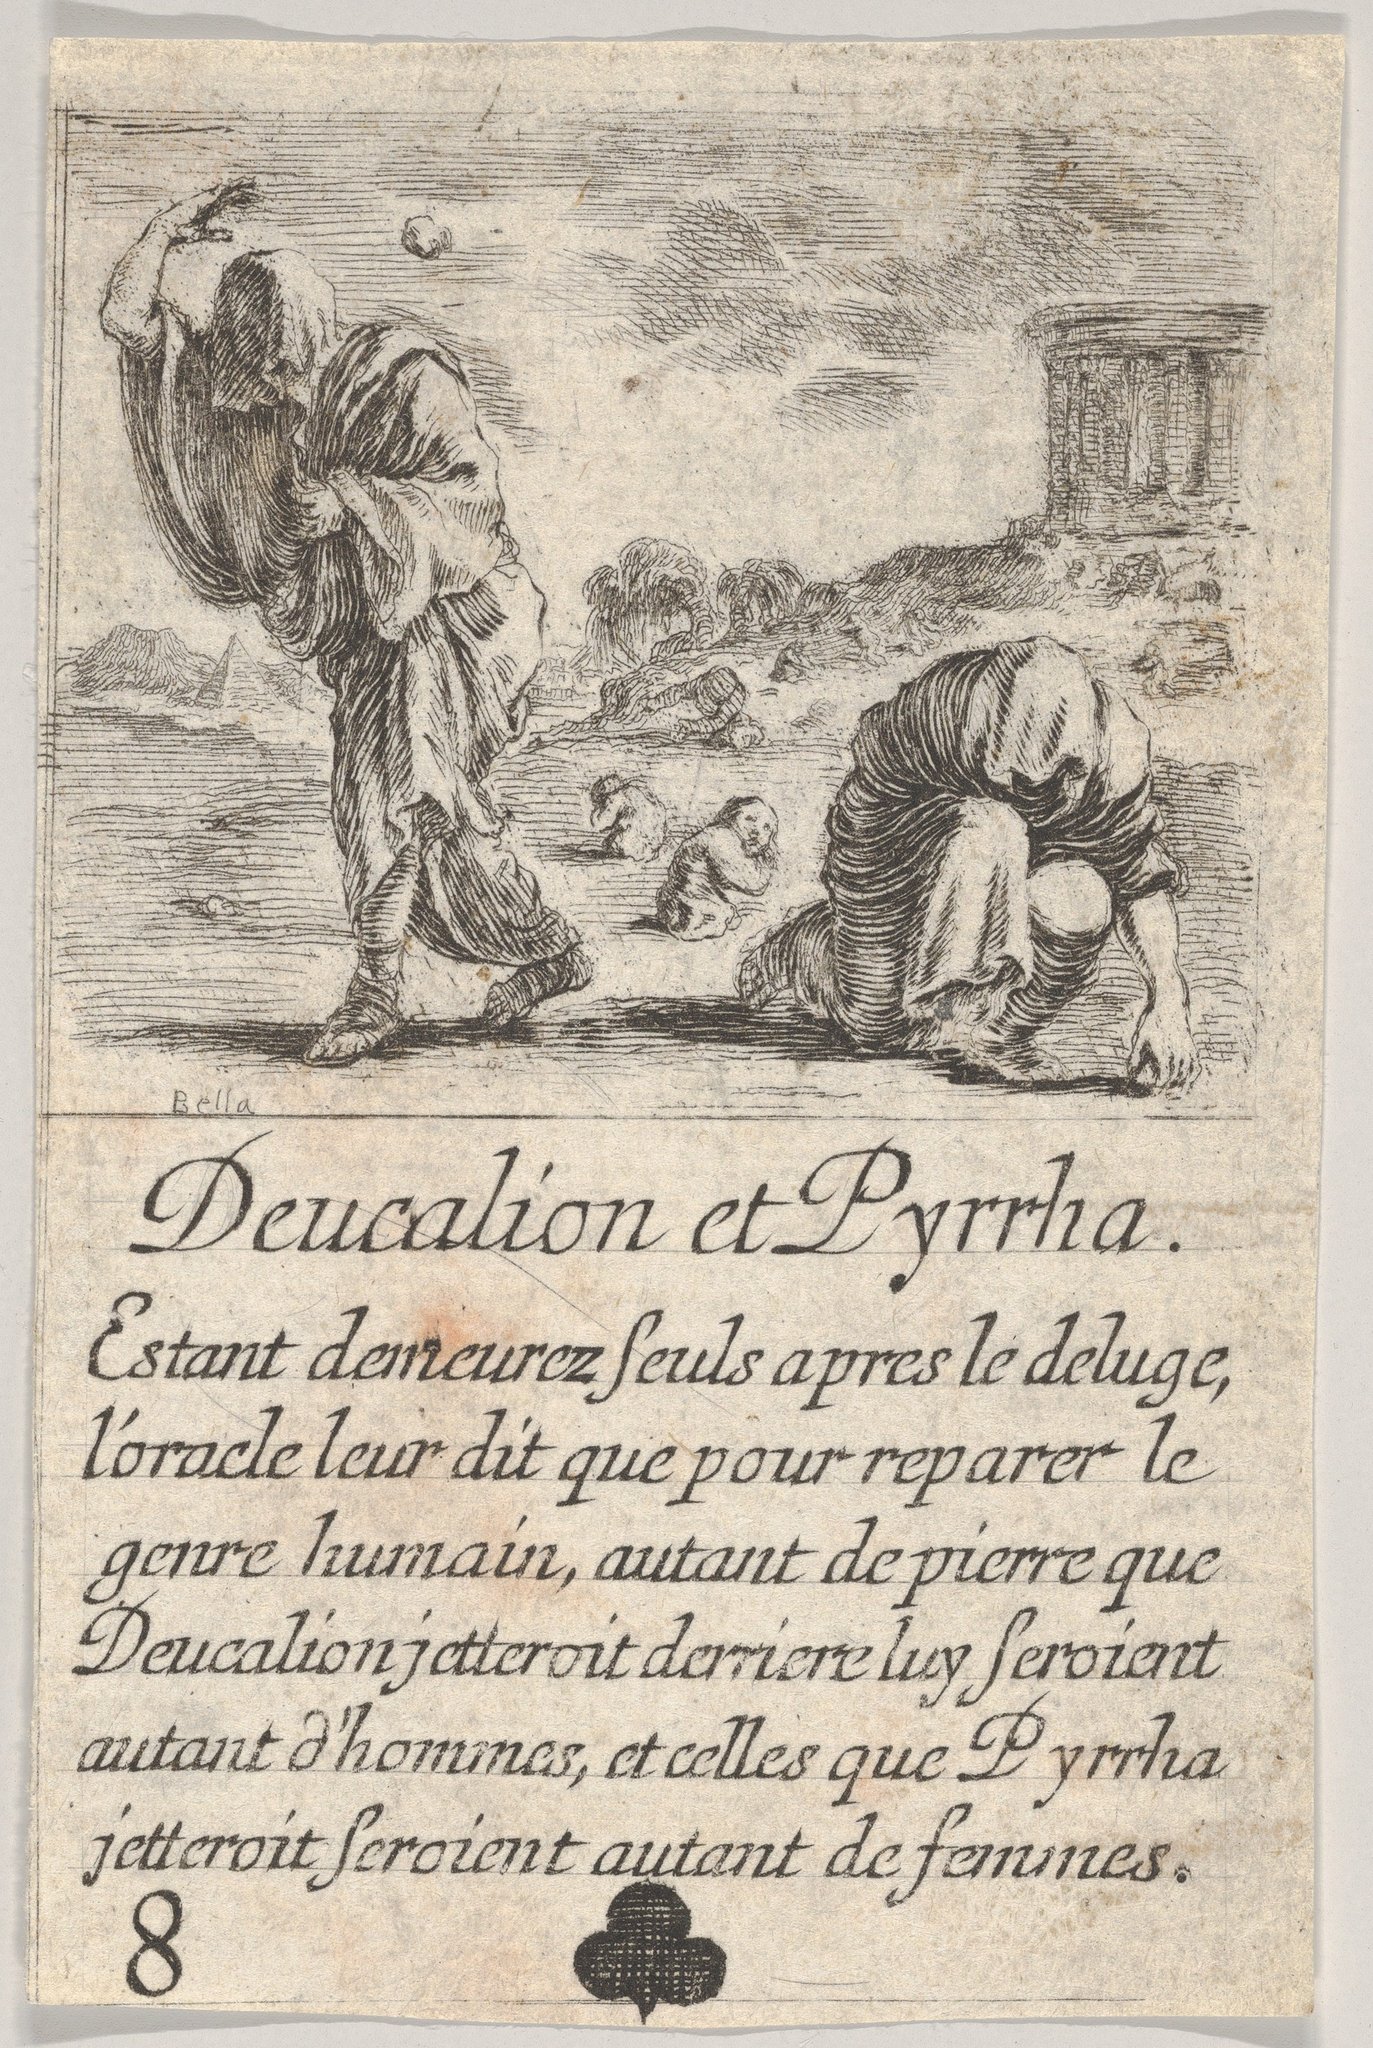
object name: print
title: Deucalion and Pyrrha, from "Game of Mythology" (Jeu de la Mythologie)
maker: stefano della bella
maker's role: artist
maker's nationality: italian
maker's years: 1610-1664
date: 1644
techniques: etching